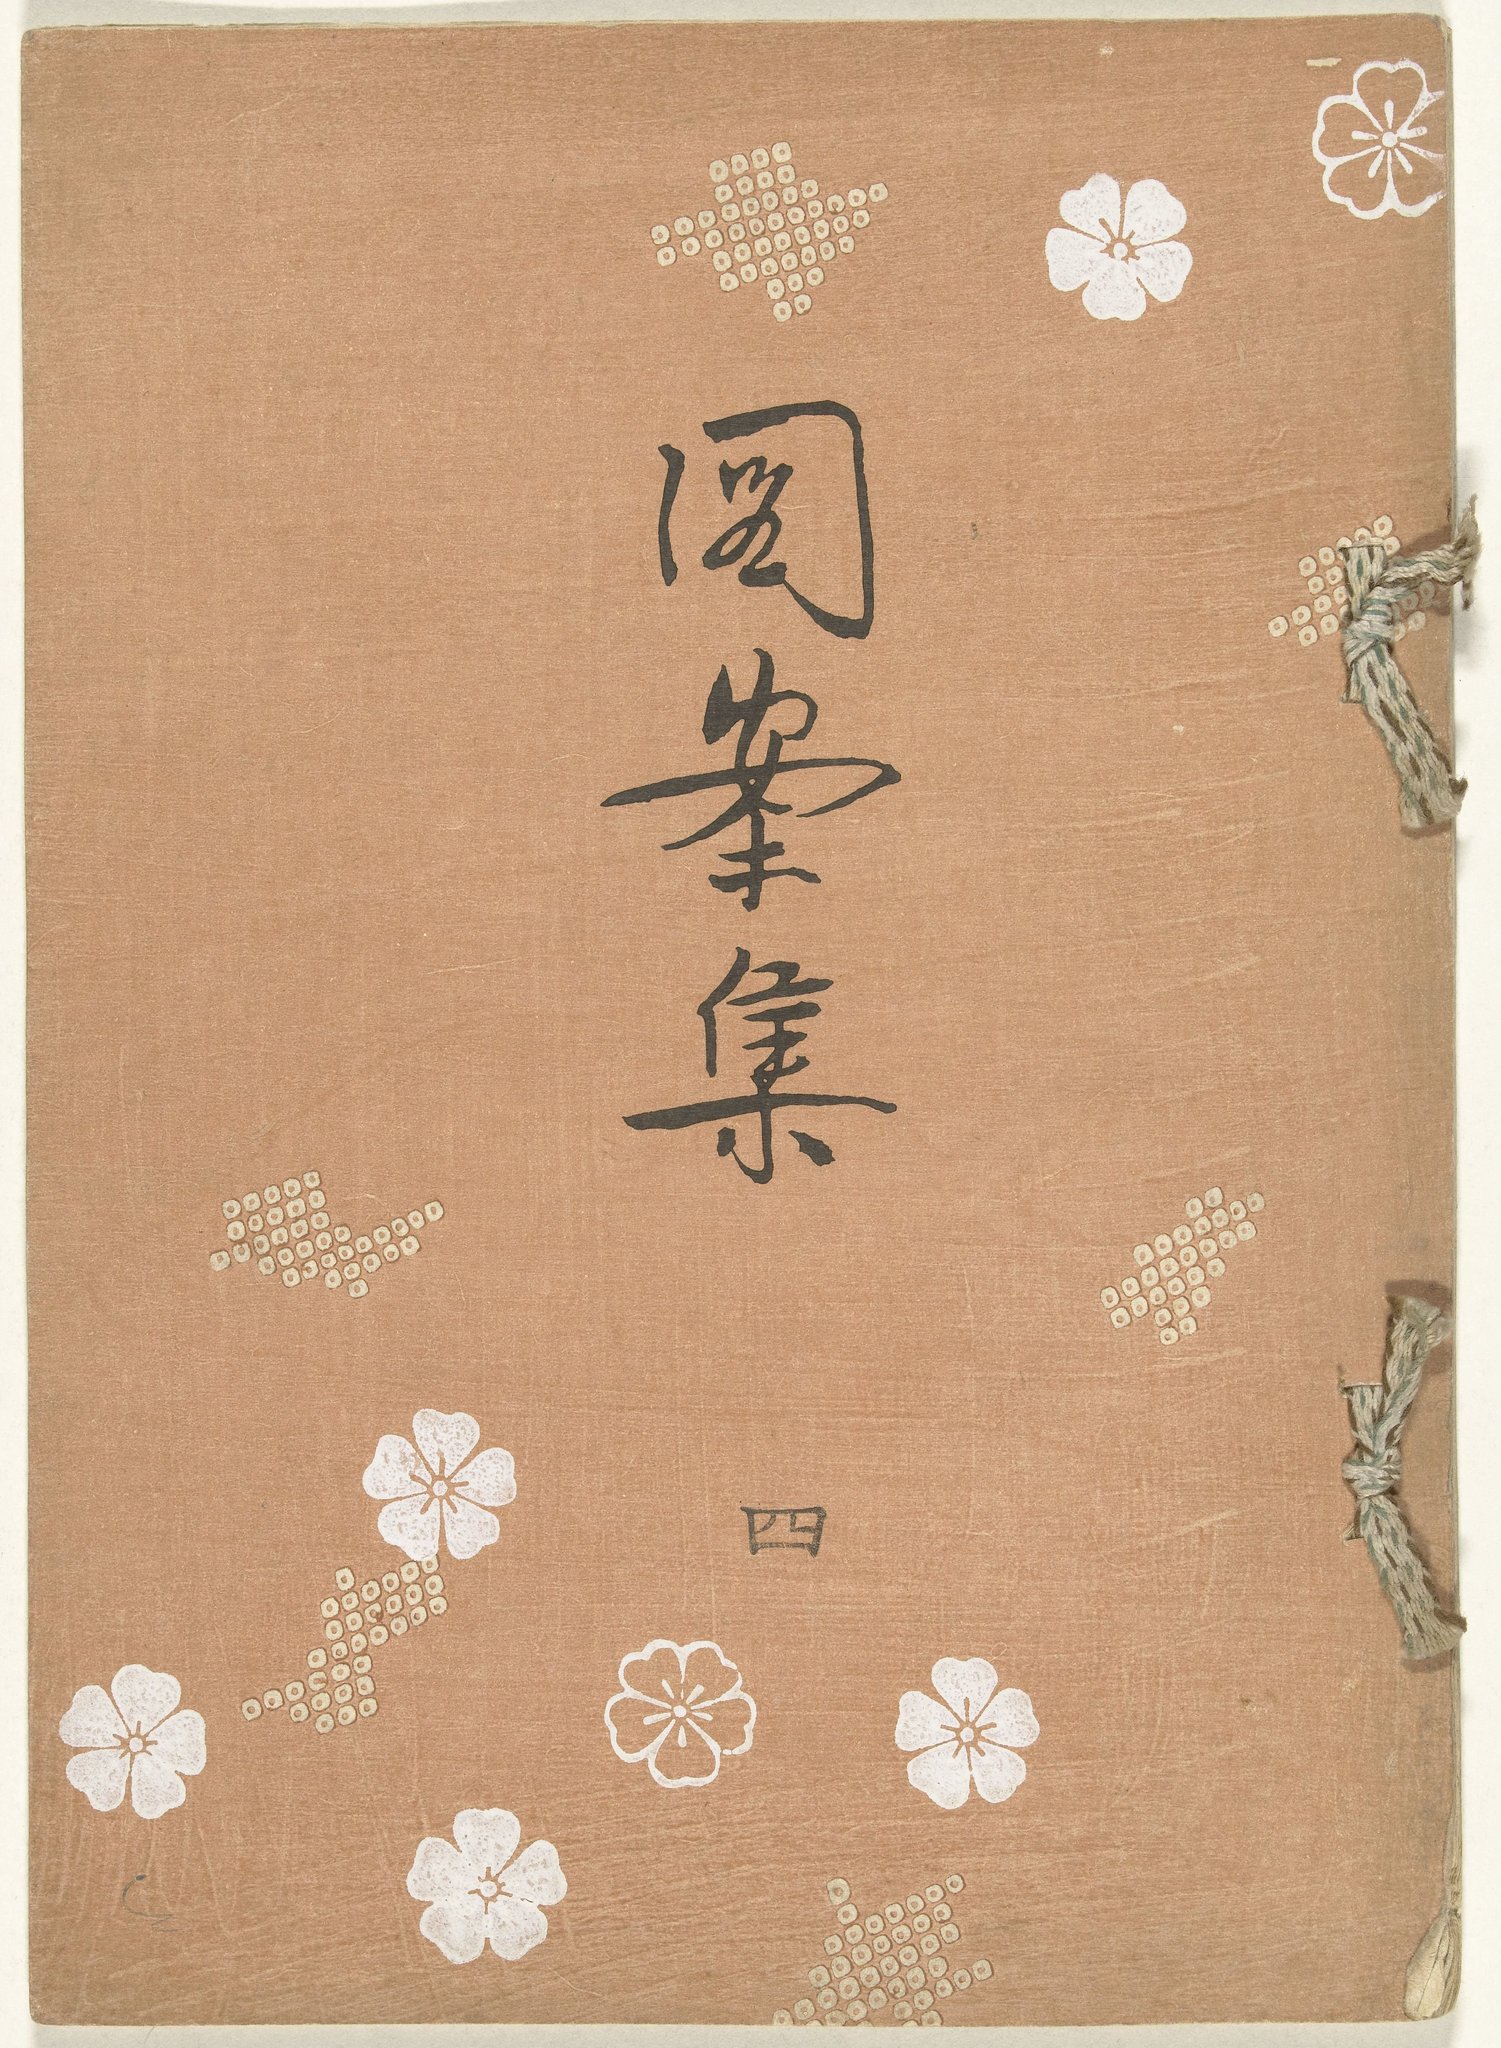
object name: book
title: Zuan shu yon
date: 1900-1912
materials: gold powder, paper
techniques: woodcut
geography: kyoto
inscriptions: date